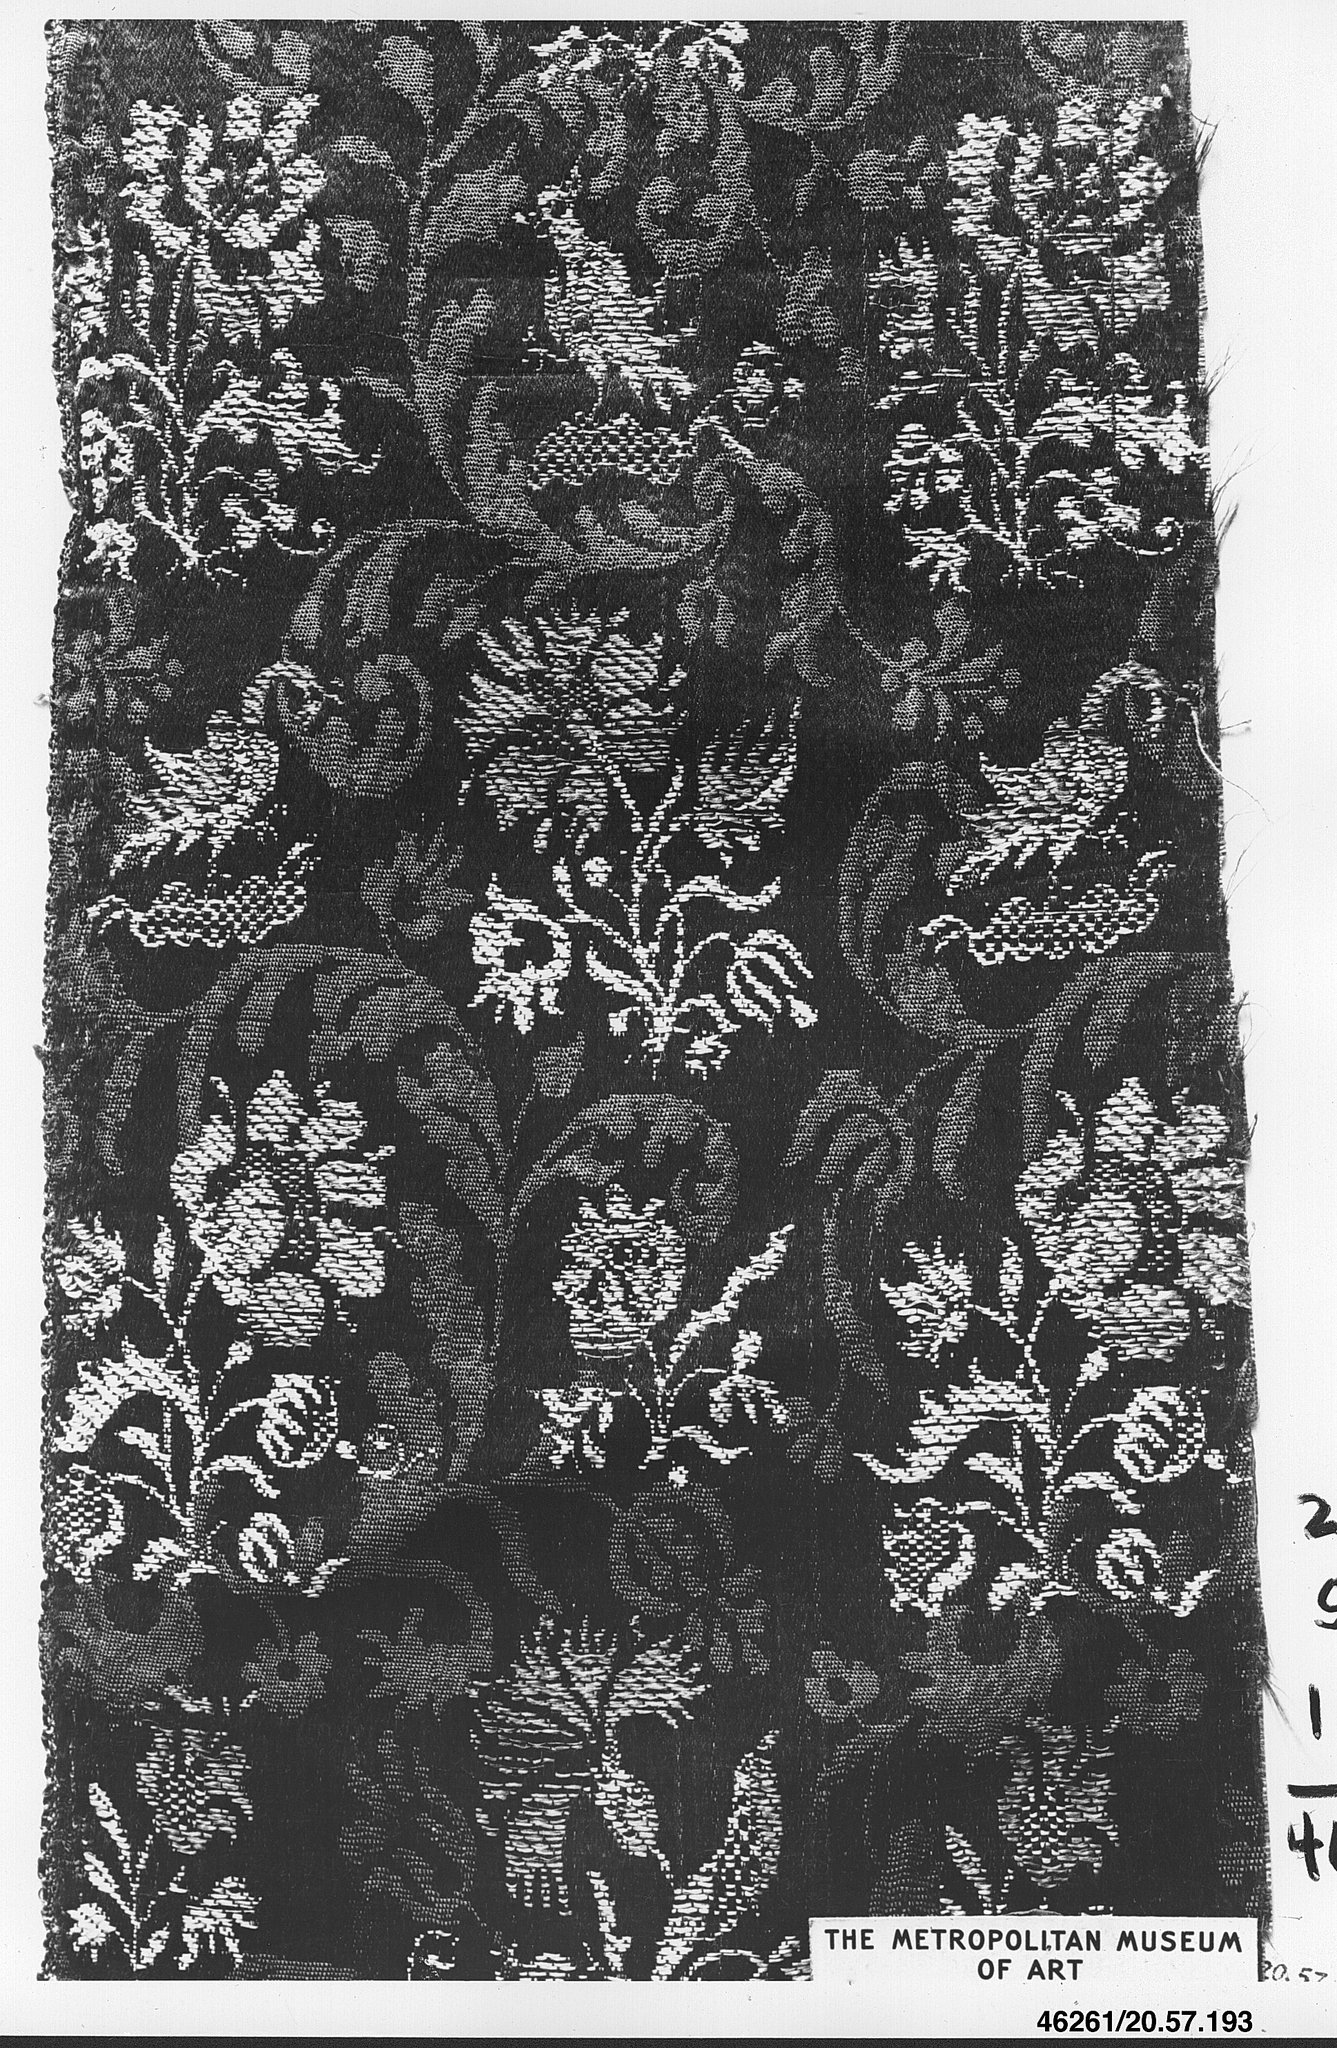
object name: piece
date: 1601-1650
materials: silk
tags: birds,flowers,leaves